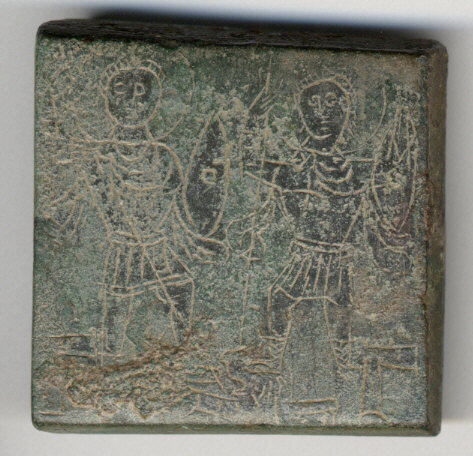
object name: weight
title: Balance Weight with Two Emperors Hunting a Snake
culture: byzantine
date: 301-500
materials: copper alloy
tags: hunting,snakes